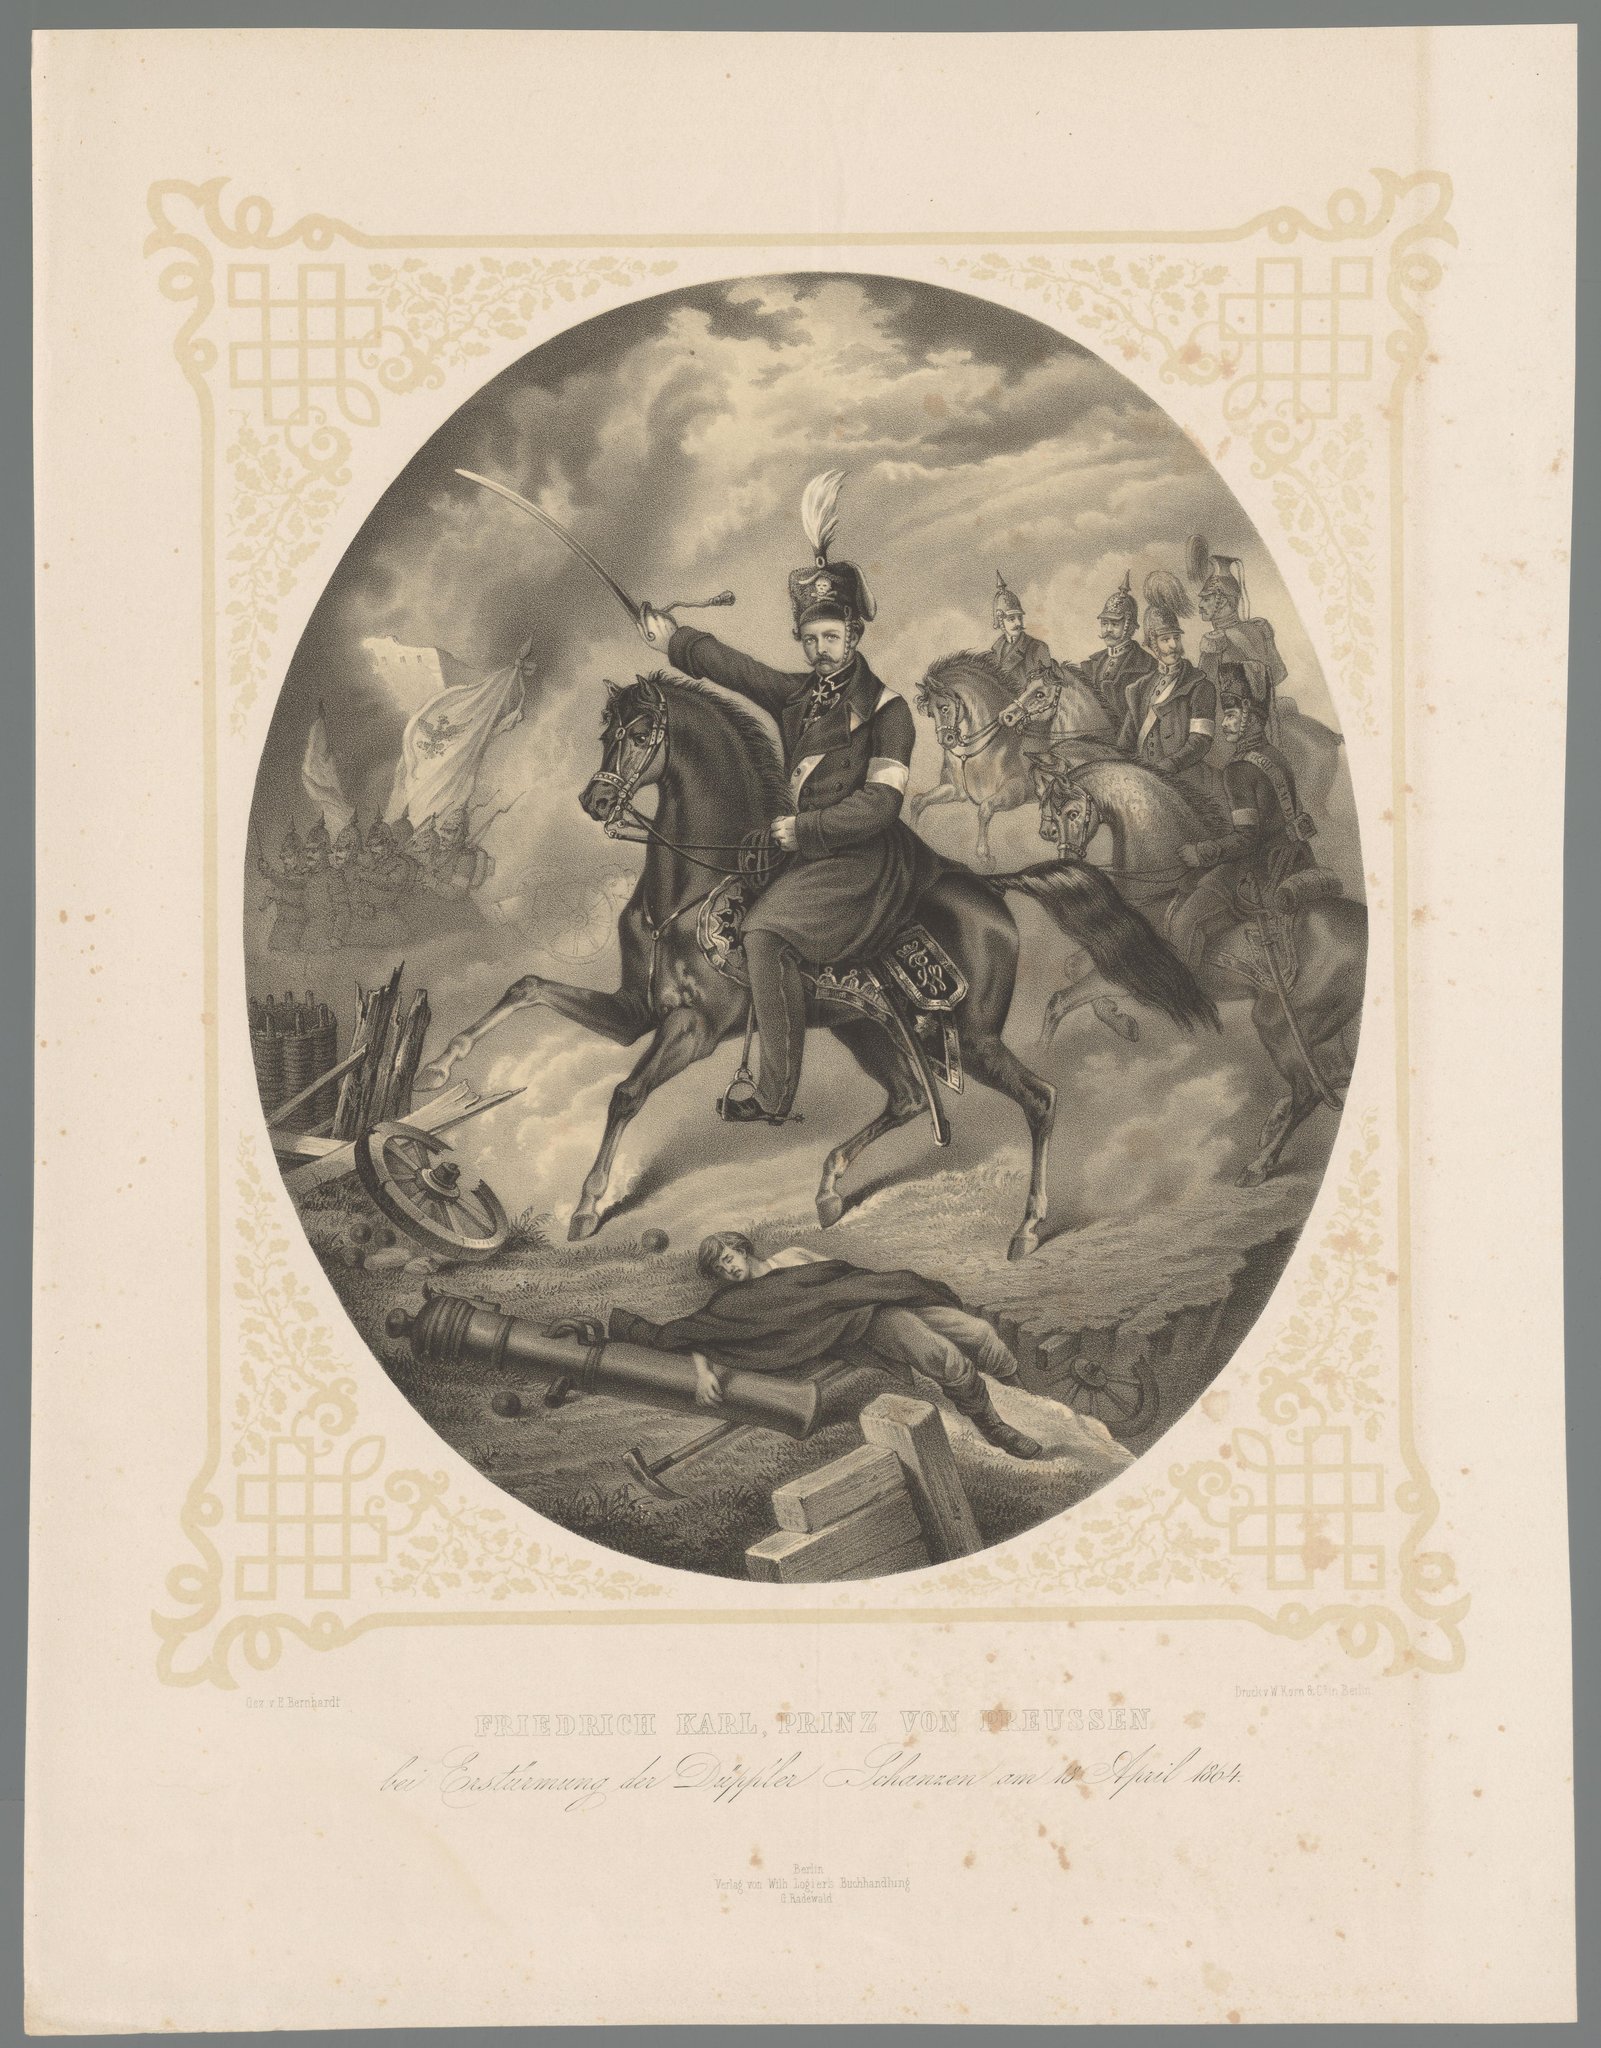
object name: print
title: Frederik Karel Nicolaas bij de bestorming van de Düppeler Schanzen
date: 1864-1899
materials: paper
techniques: tone lithography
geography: berlin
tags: berlin, riding a horse, ass, or mule; rider, horseman, weapons, (military) attack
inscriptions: collector's mark: Lugt 2228